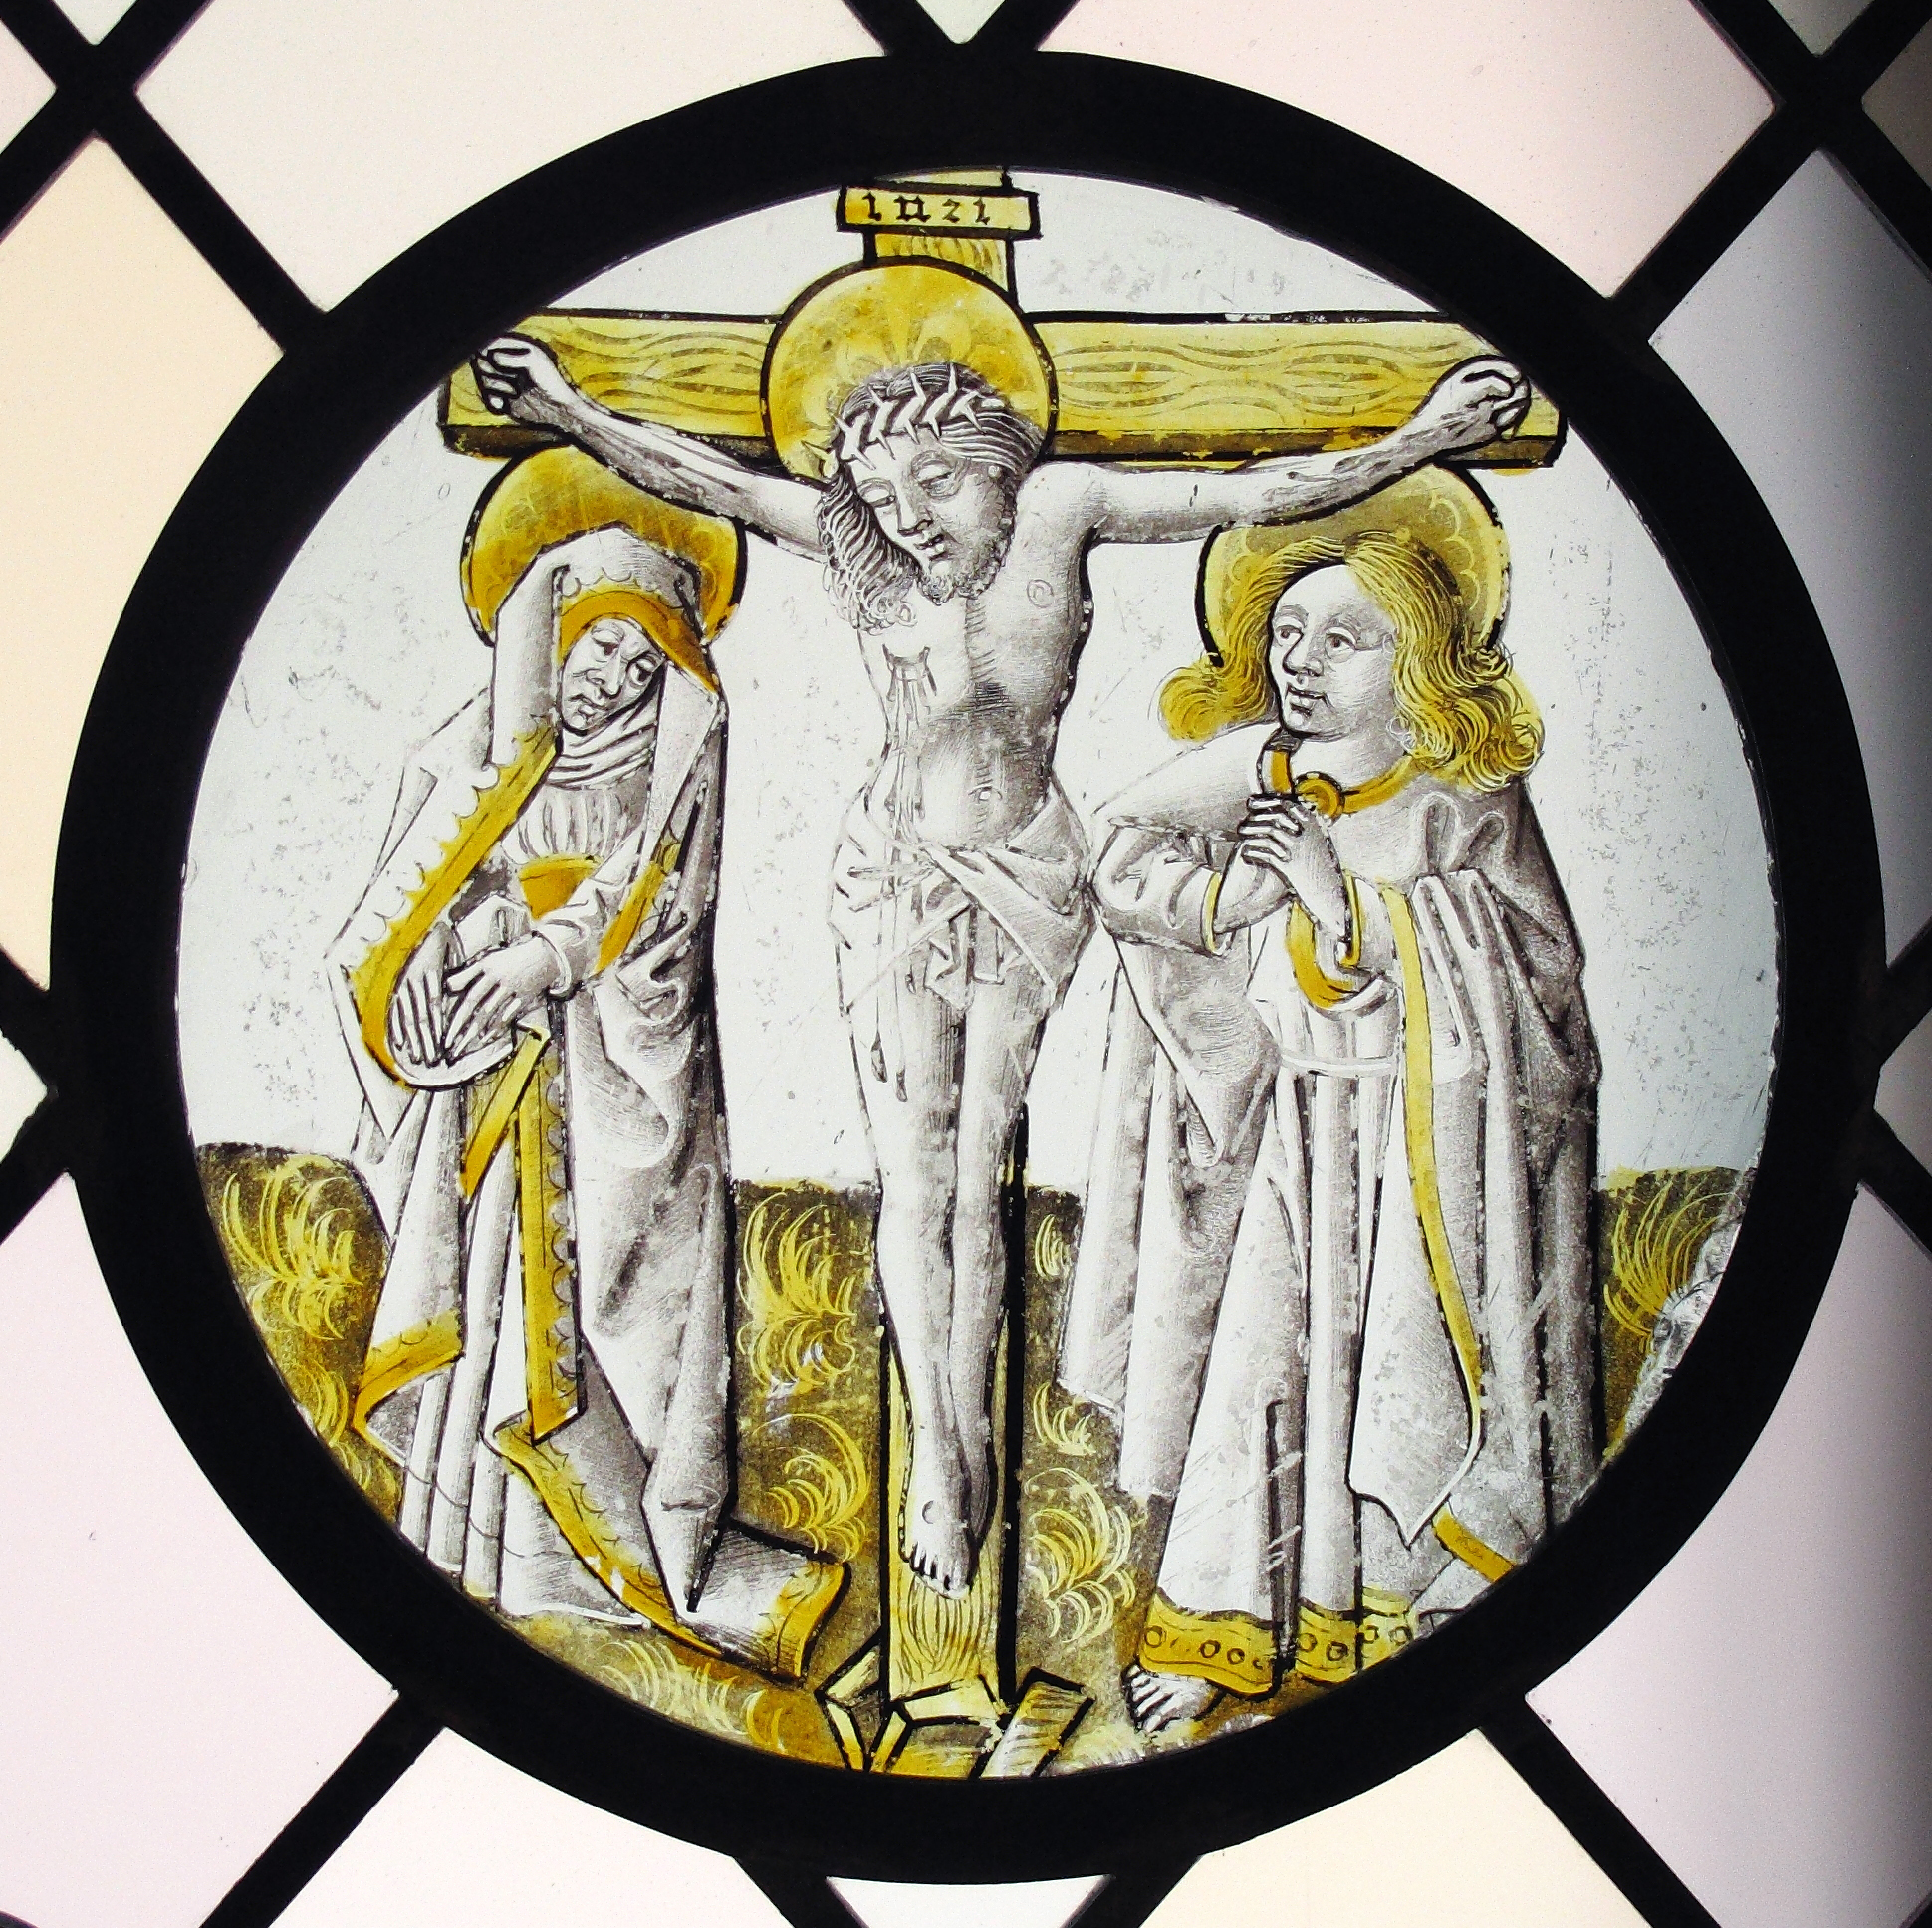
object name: roundel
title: Roundel with Crucifixion, the Virgin and Saint John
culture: british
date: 1480-1500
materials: glass, paint, pigment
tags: christ,virgin mary,crucifixion